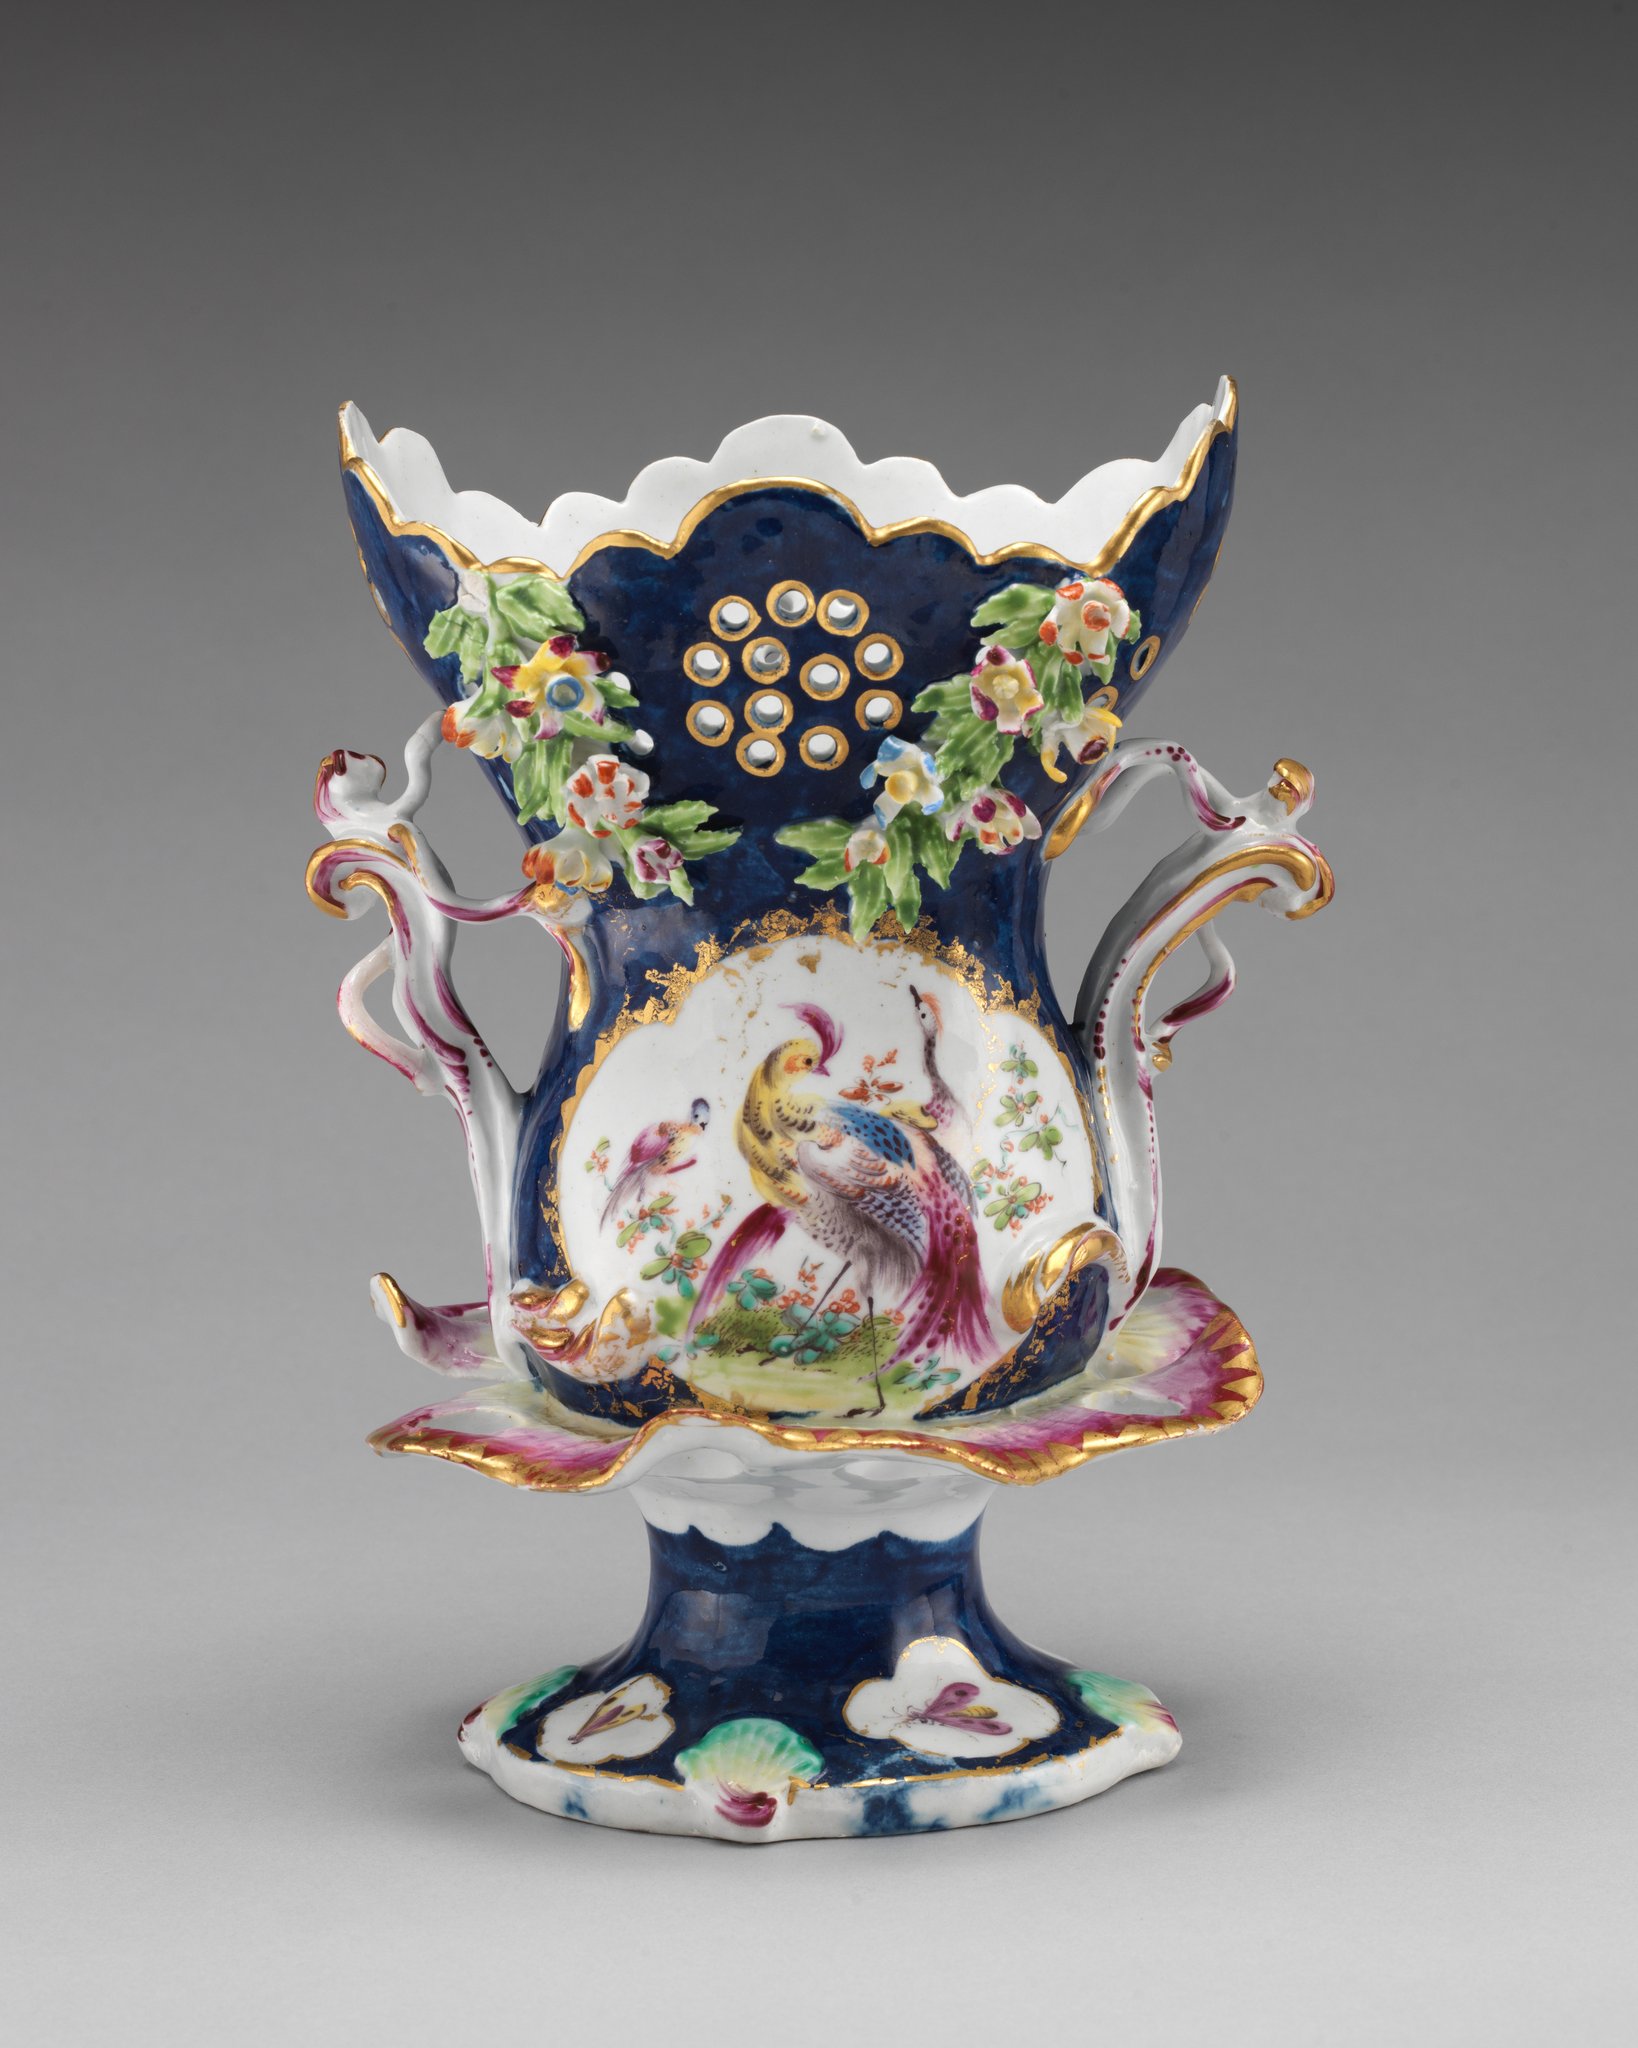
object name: beaker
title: Beaker (part of a garniture)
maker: bow porcelain factory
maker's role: factory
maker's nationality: british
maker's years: 1747-1776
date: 1765-1770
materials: soft paste porcelain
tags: birds